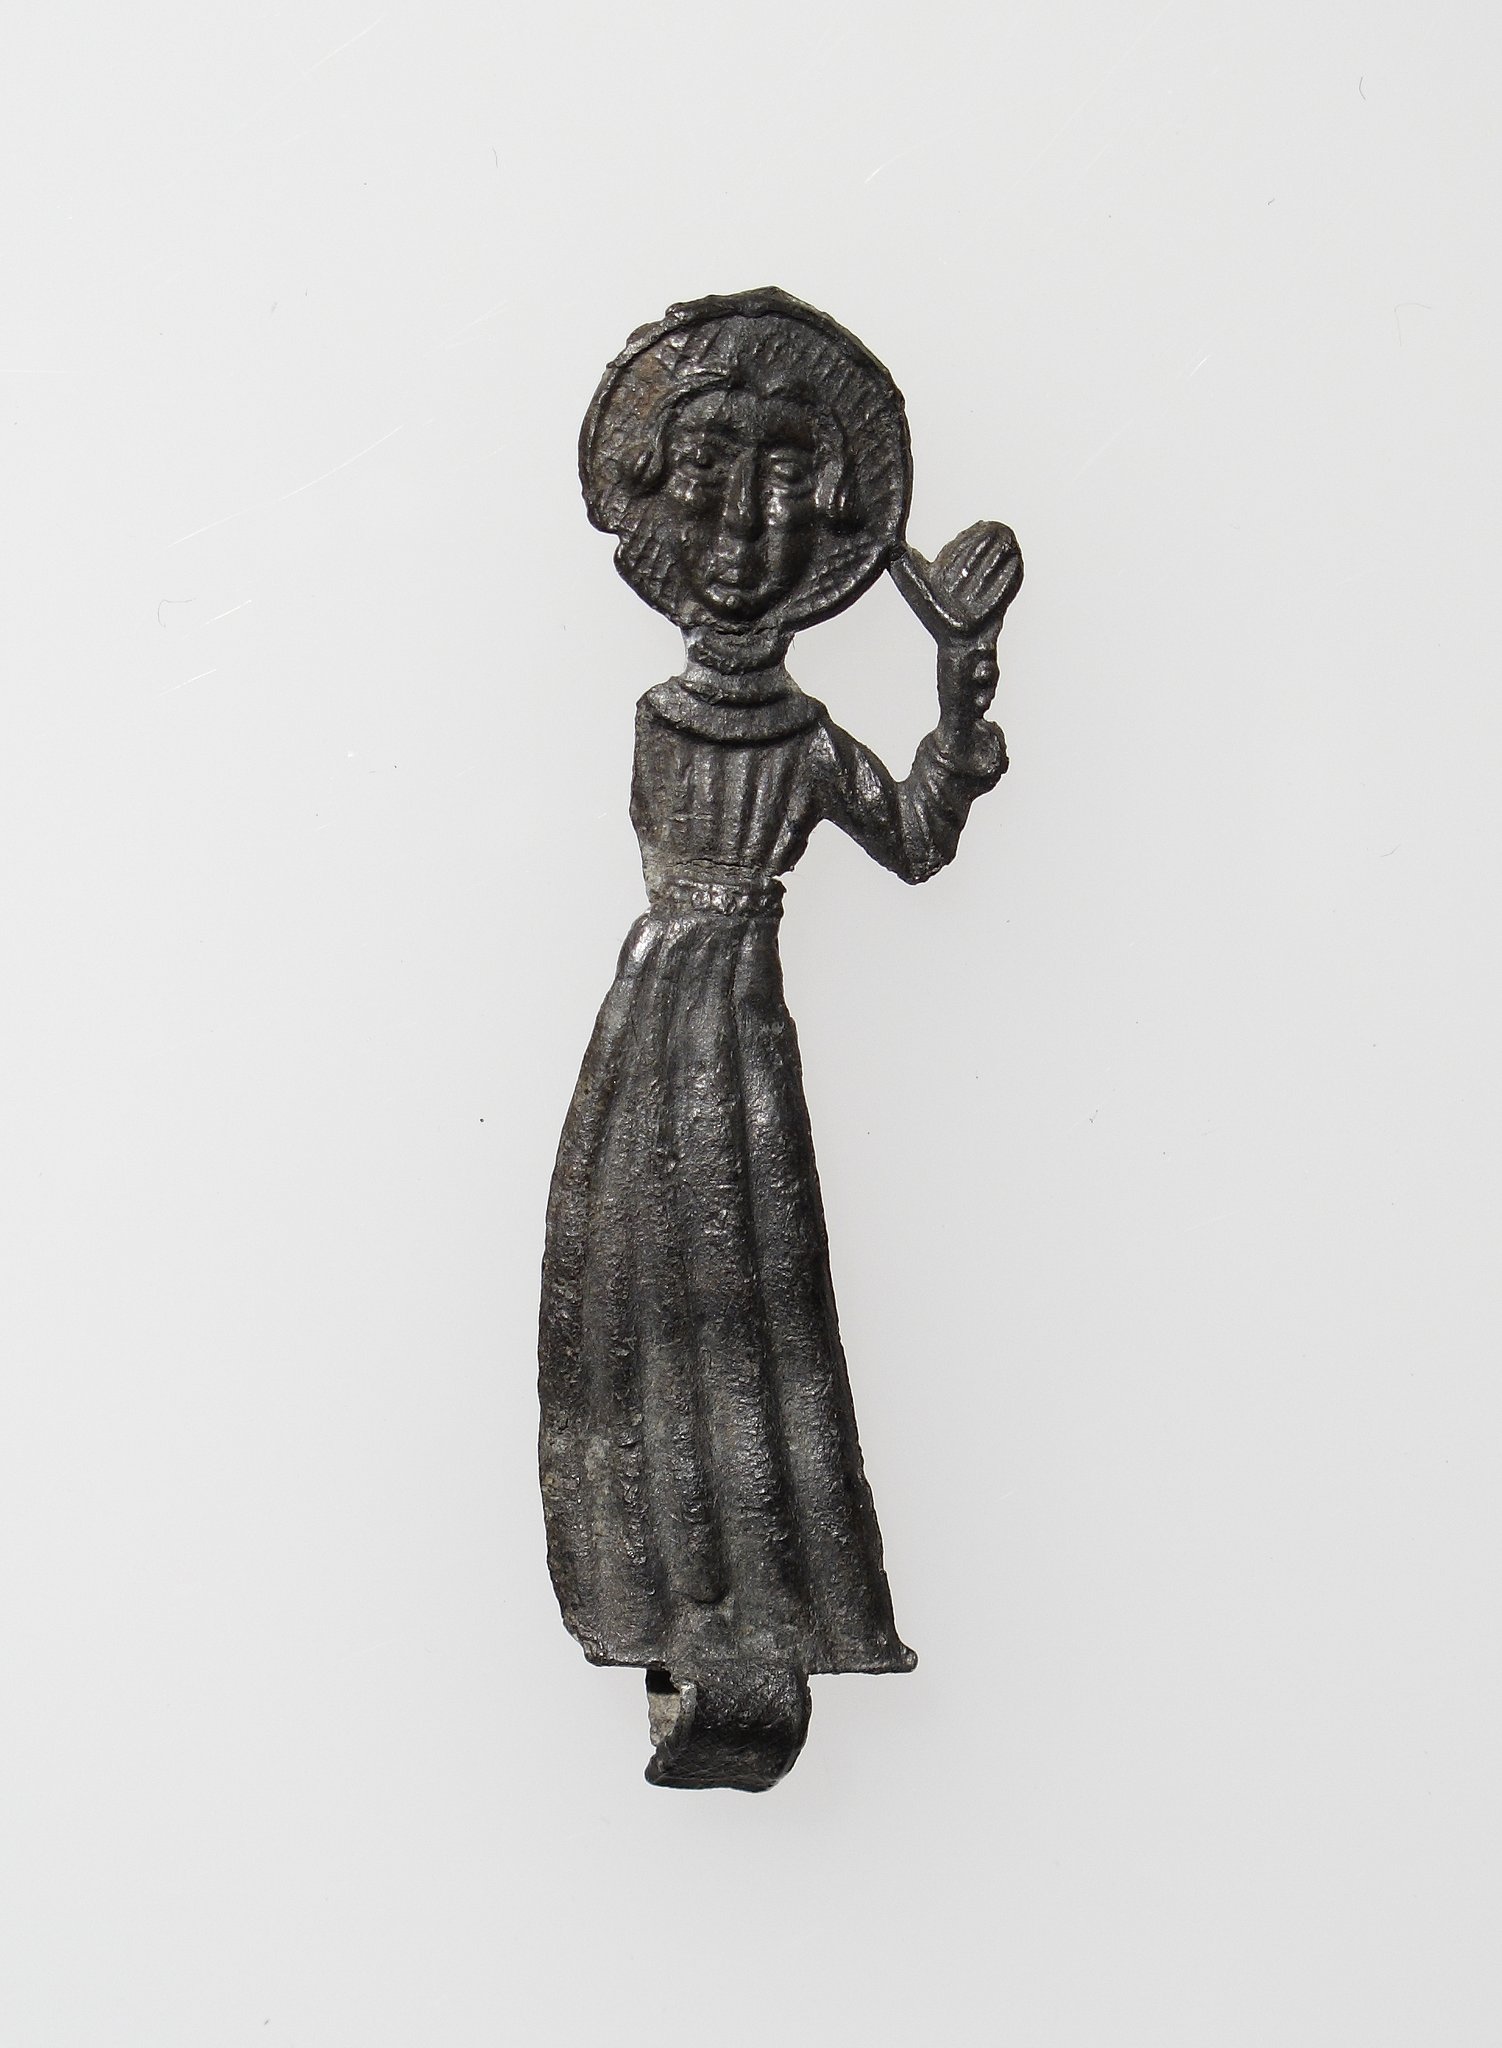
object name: pilgrim's badge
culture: french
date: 1301-1600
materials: lead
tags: saints